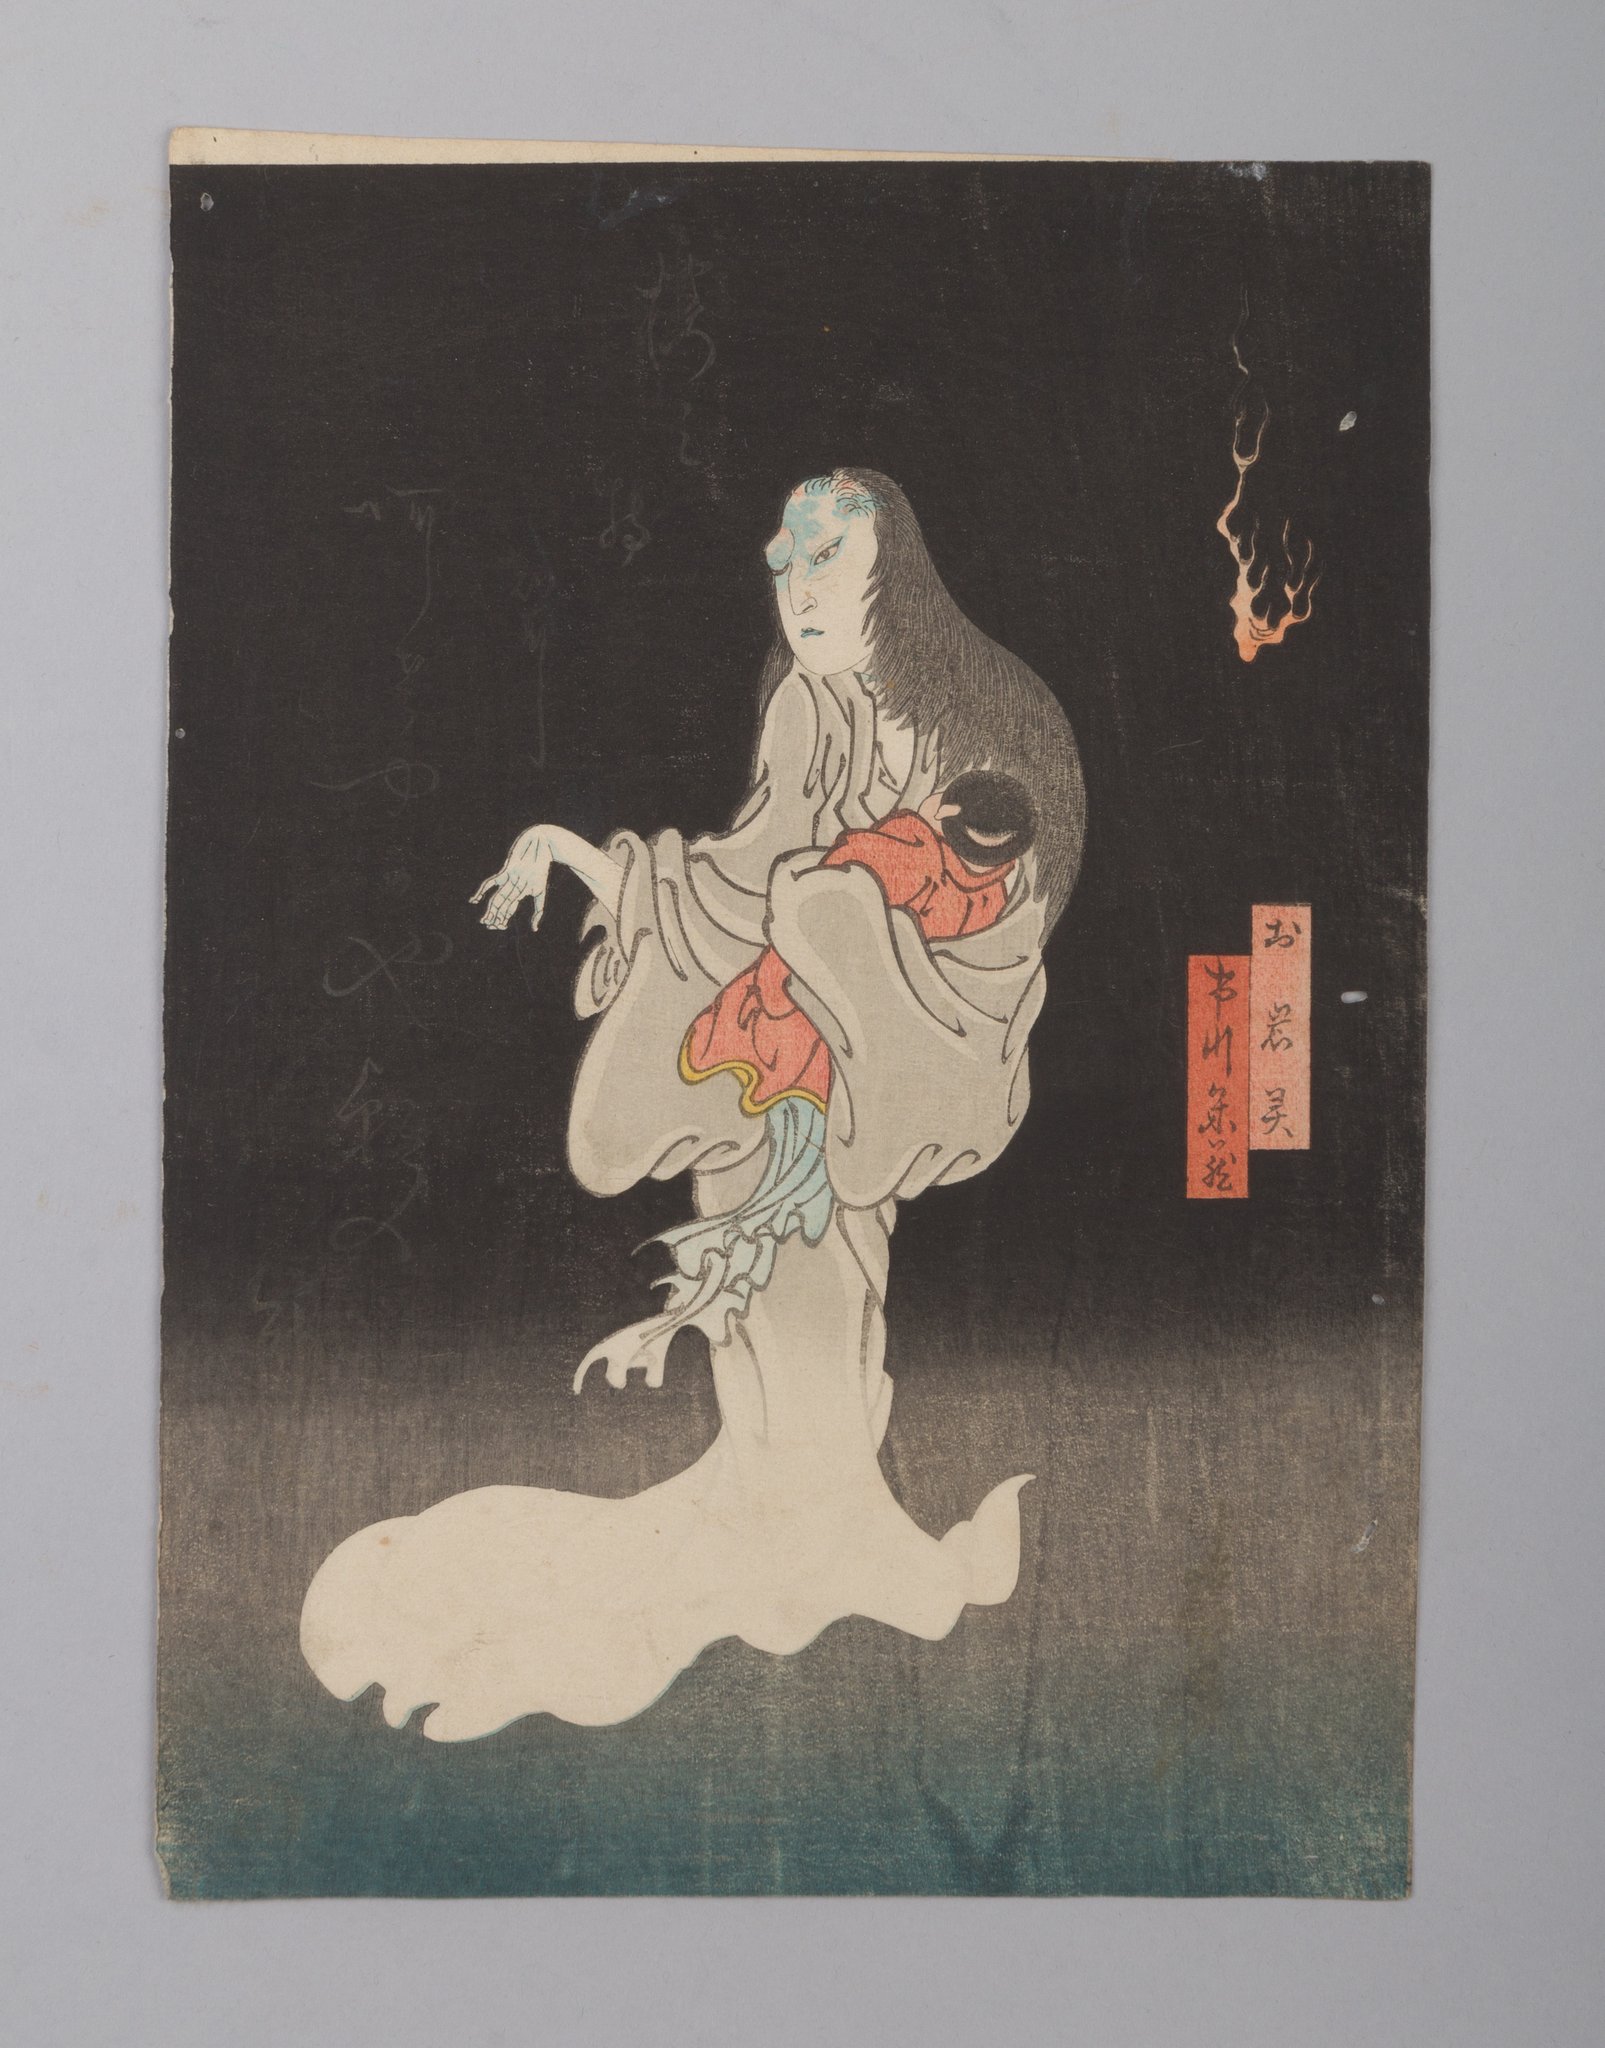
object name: woodblock print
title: Ichikawa Yonezō as the Ghost of Oiwa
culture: japanese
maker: enjaku 猿雀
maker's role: artist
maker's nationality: japanese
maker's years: 1850-1870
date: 1865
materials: ink, paper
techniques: nishiki e, woodblock print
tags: infants,men,actors